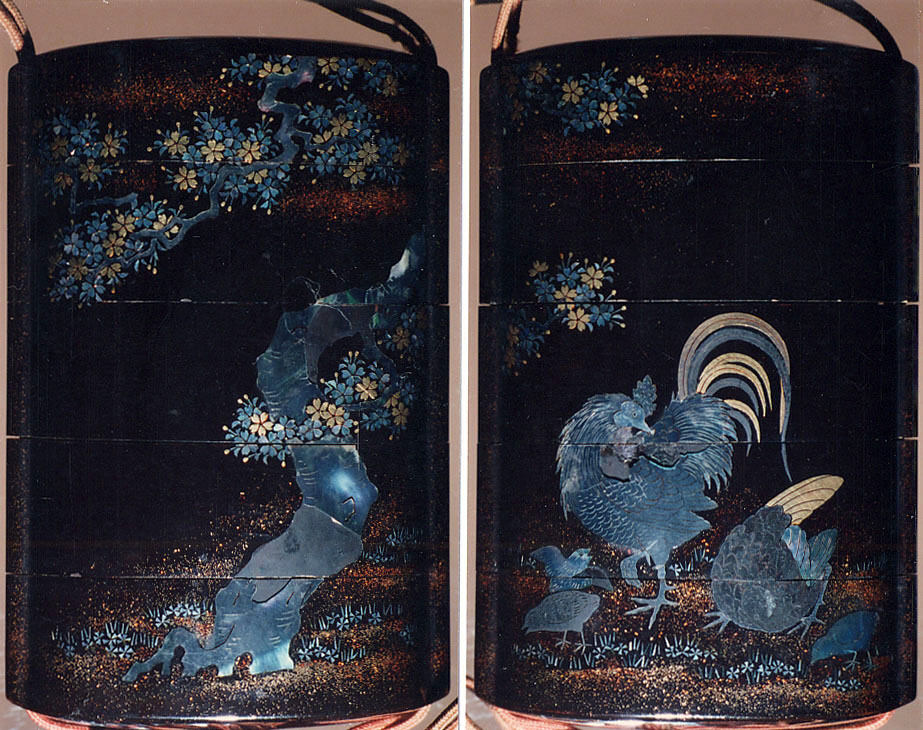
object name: inrō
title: Case (Inrō) with Design of Rooster and Chickens Beneath Flowering Cherry Tree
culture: japanese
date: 1801-1900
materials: gold foil, lacquer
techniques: fundame, inlay, roiro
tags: chickens,roosters,trees